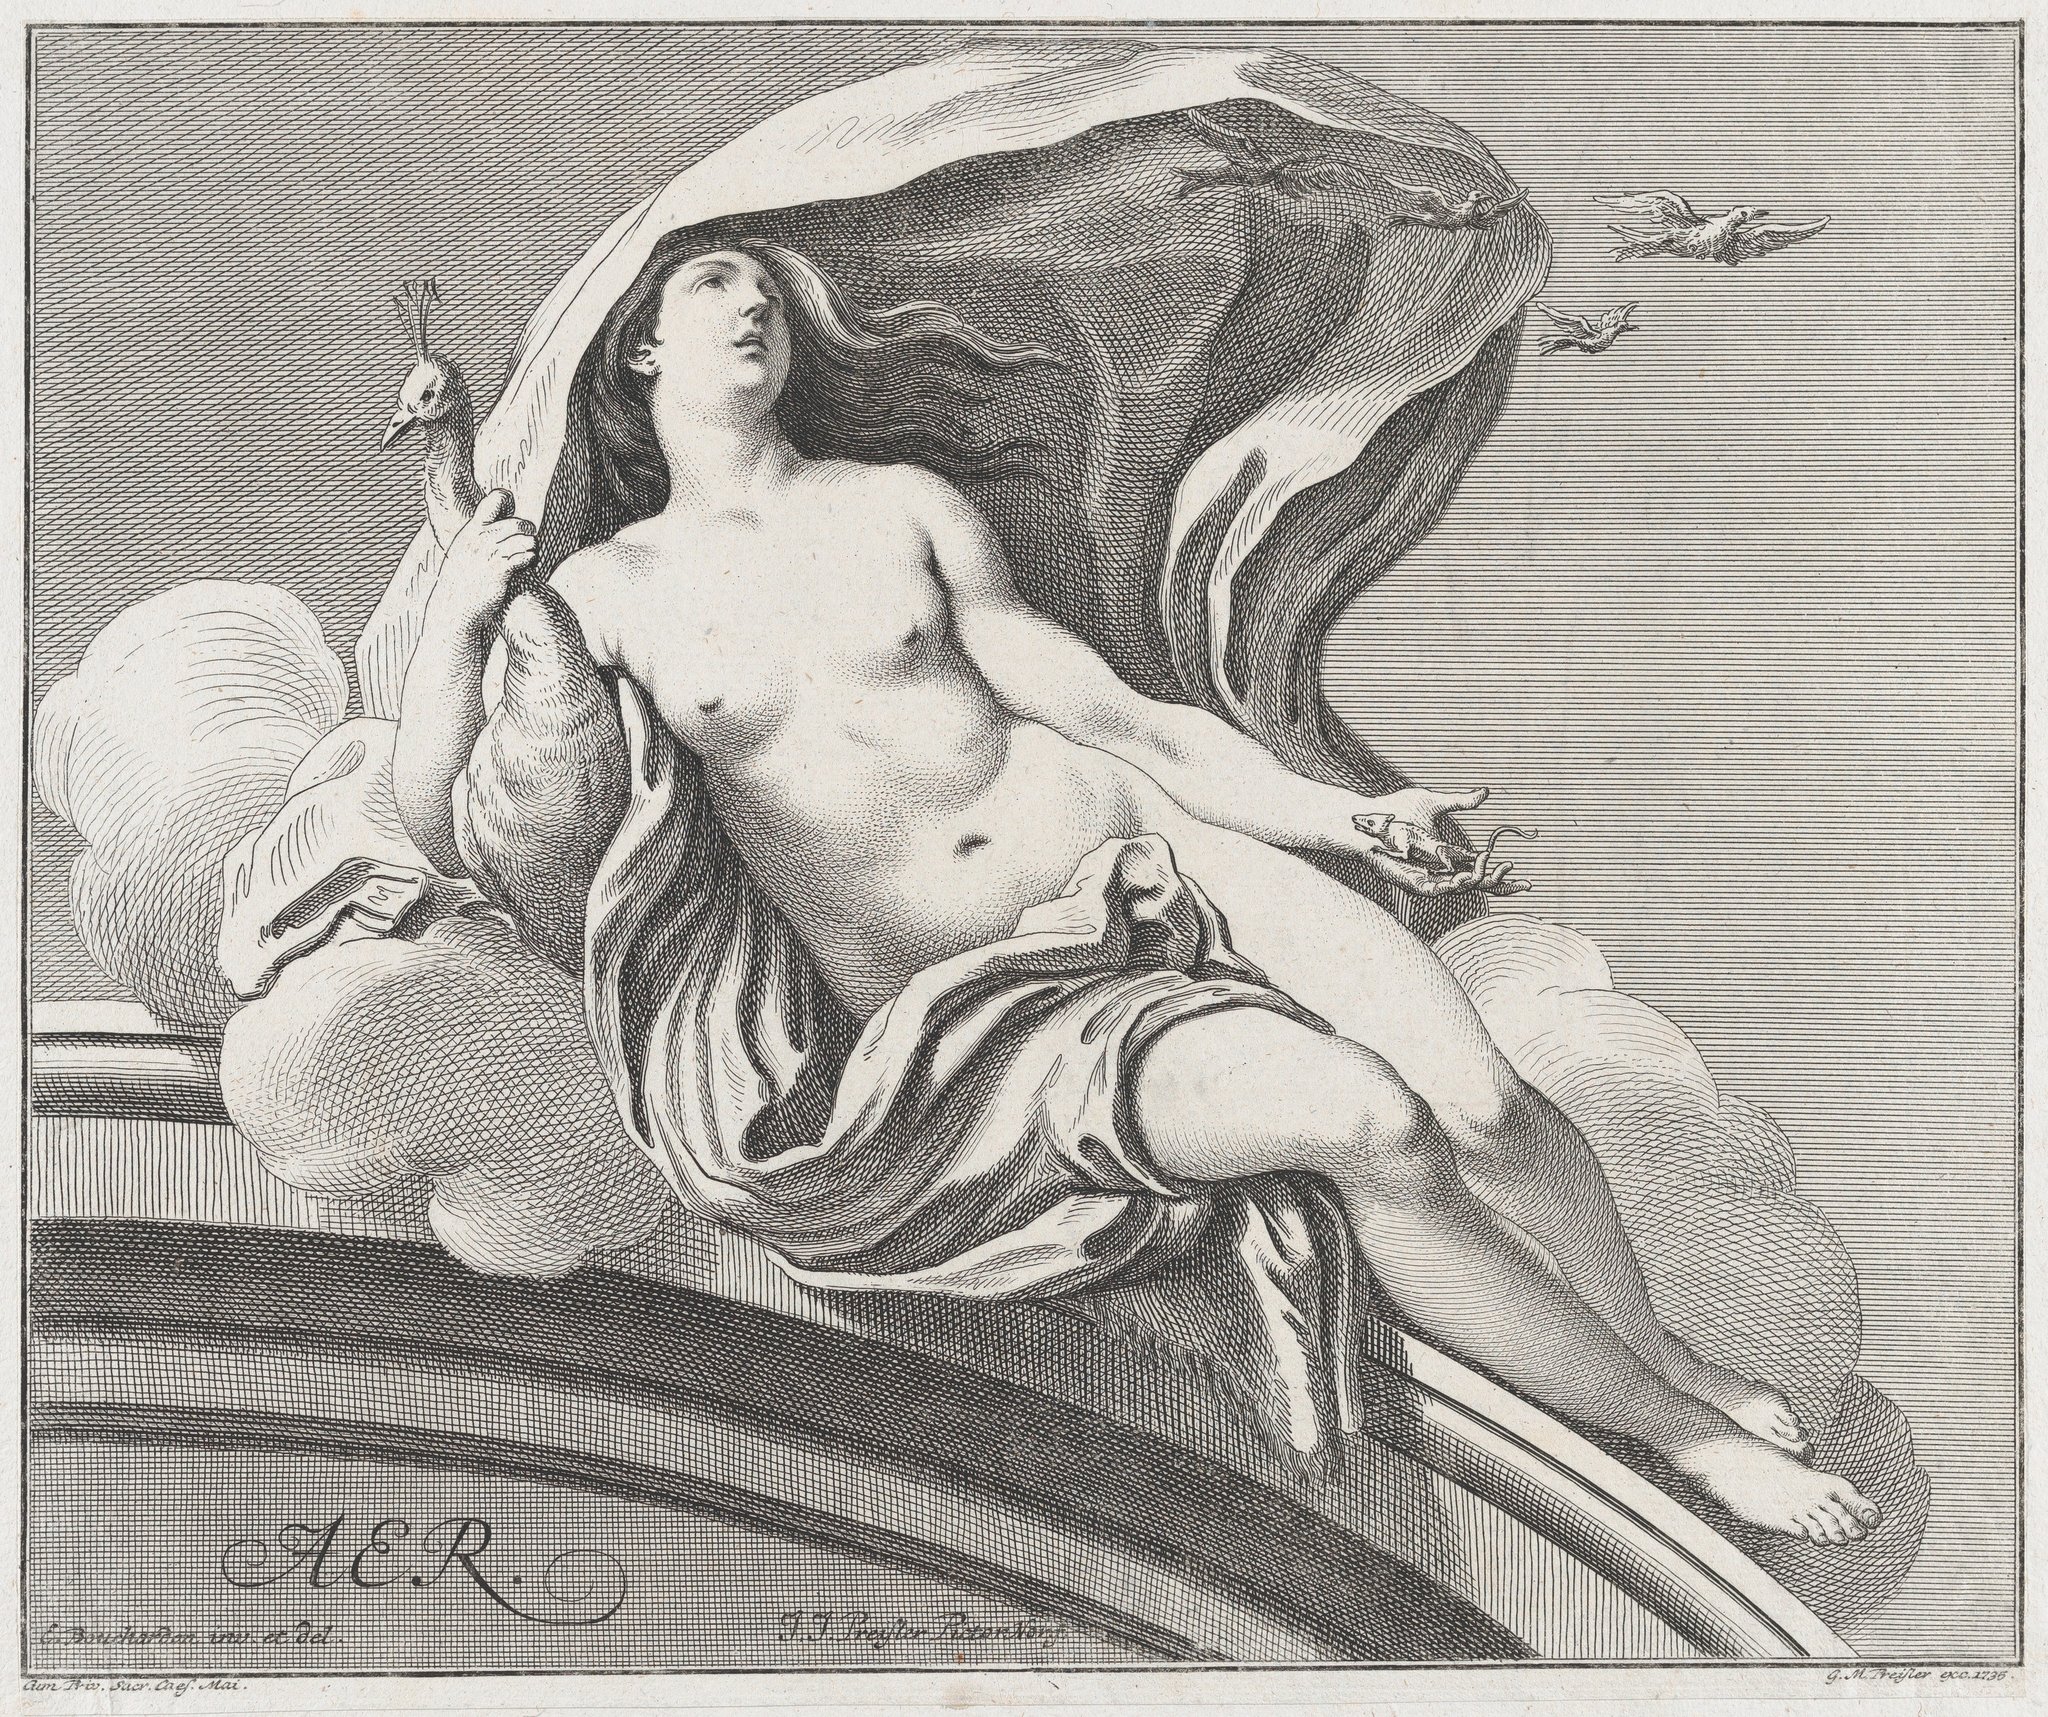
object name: print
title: Air, from "The Elements"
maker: johann justin preissler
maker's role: artist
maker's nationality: german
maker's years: 1698-1771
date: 1735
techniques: engraving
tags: birds,female nudes,peacocks